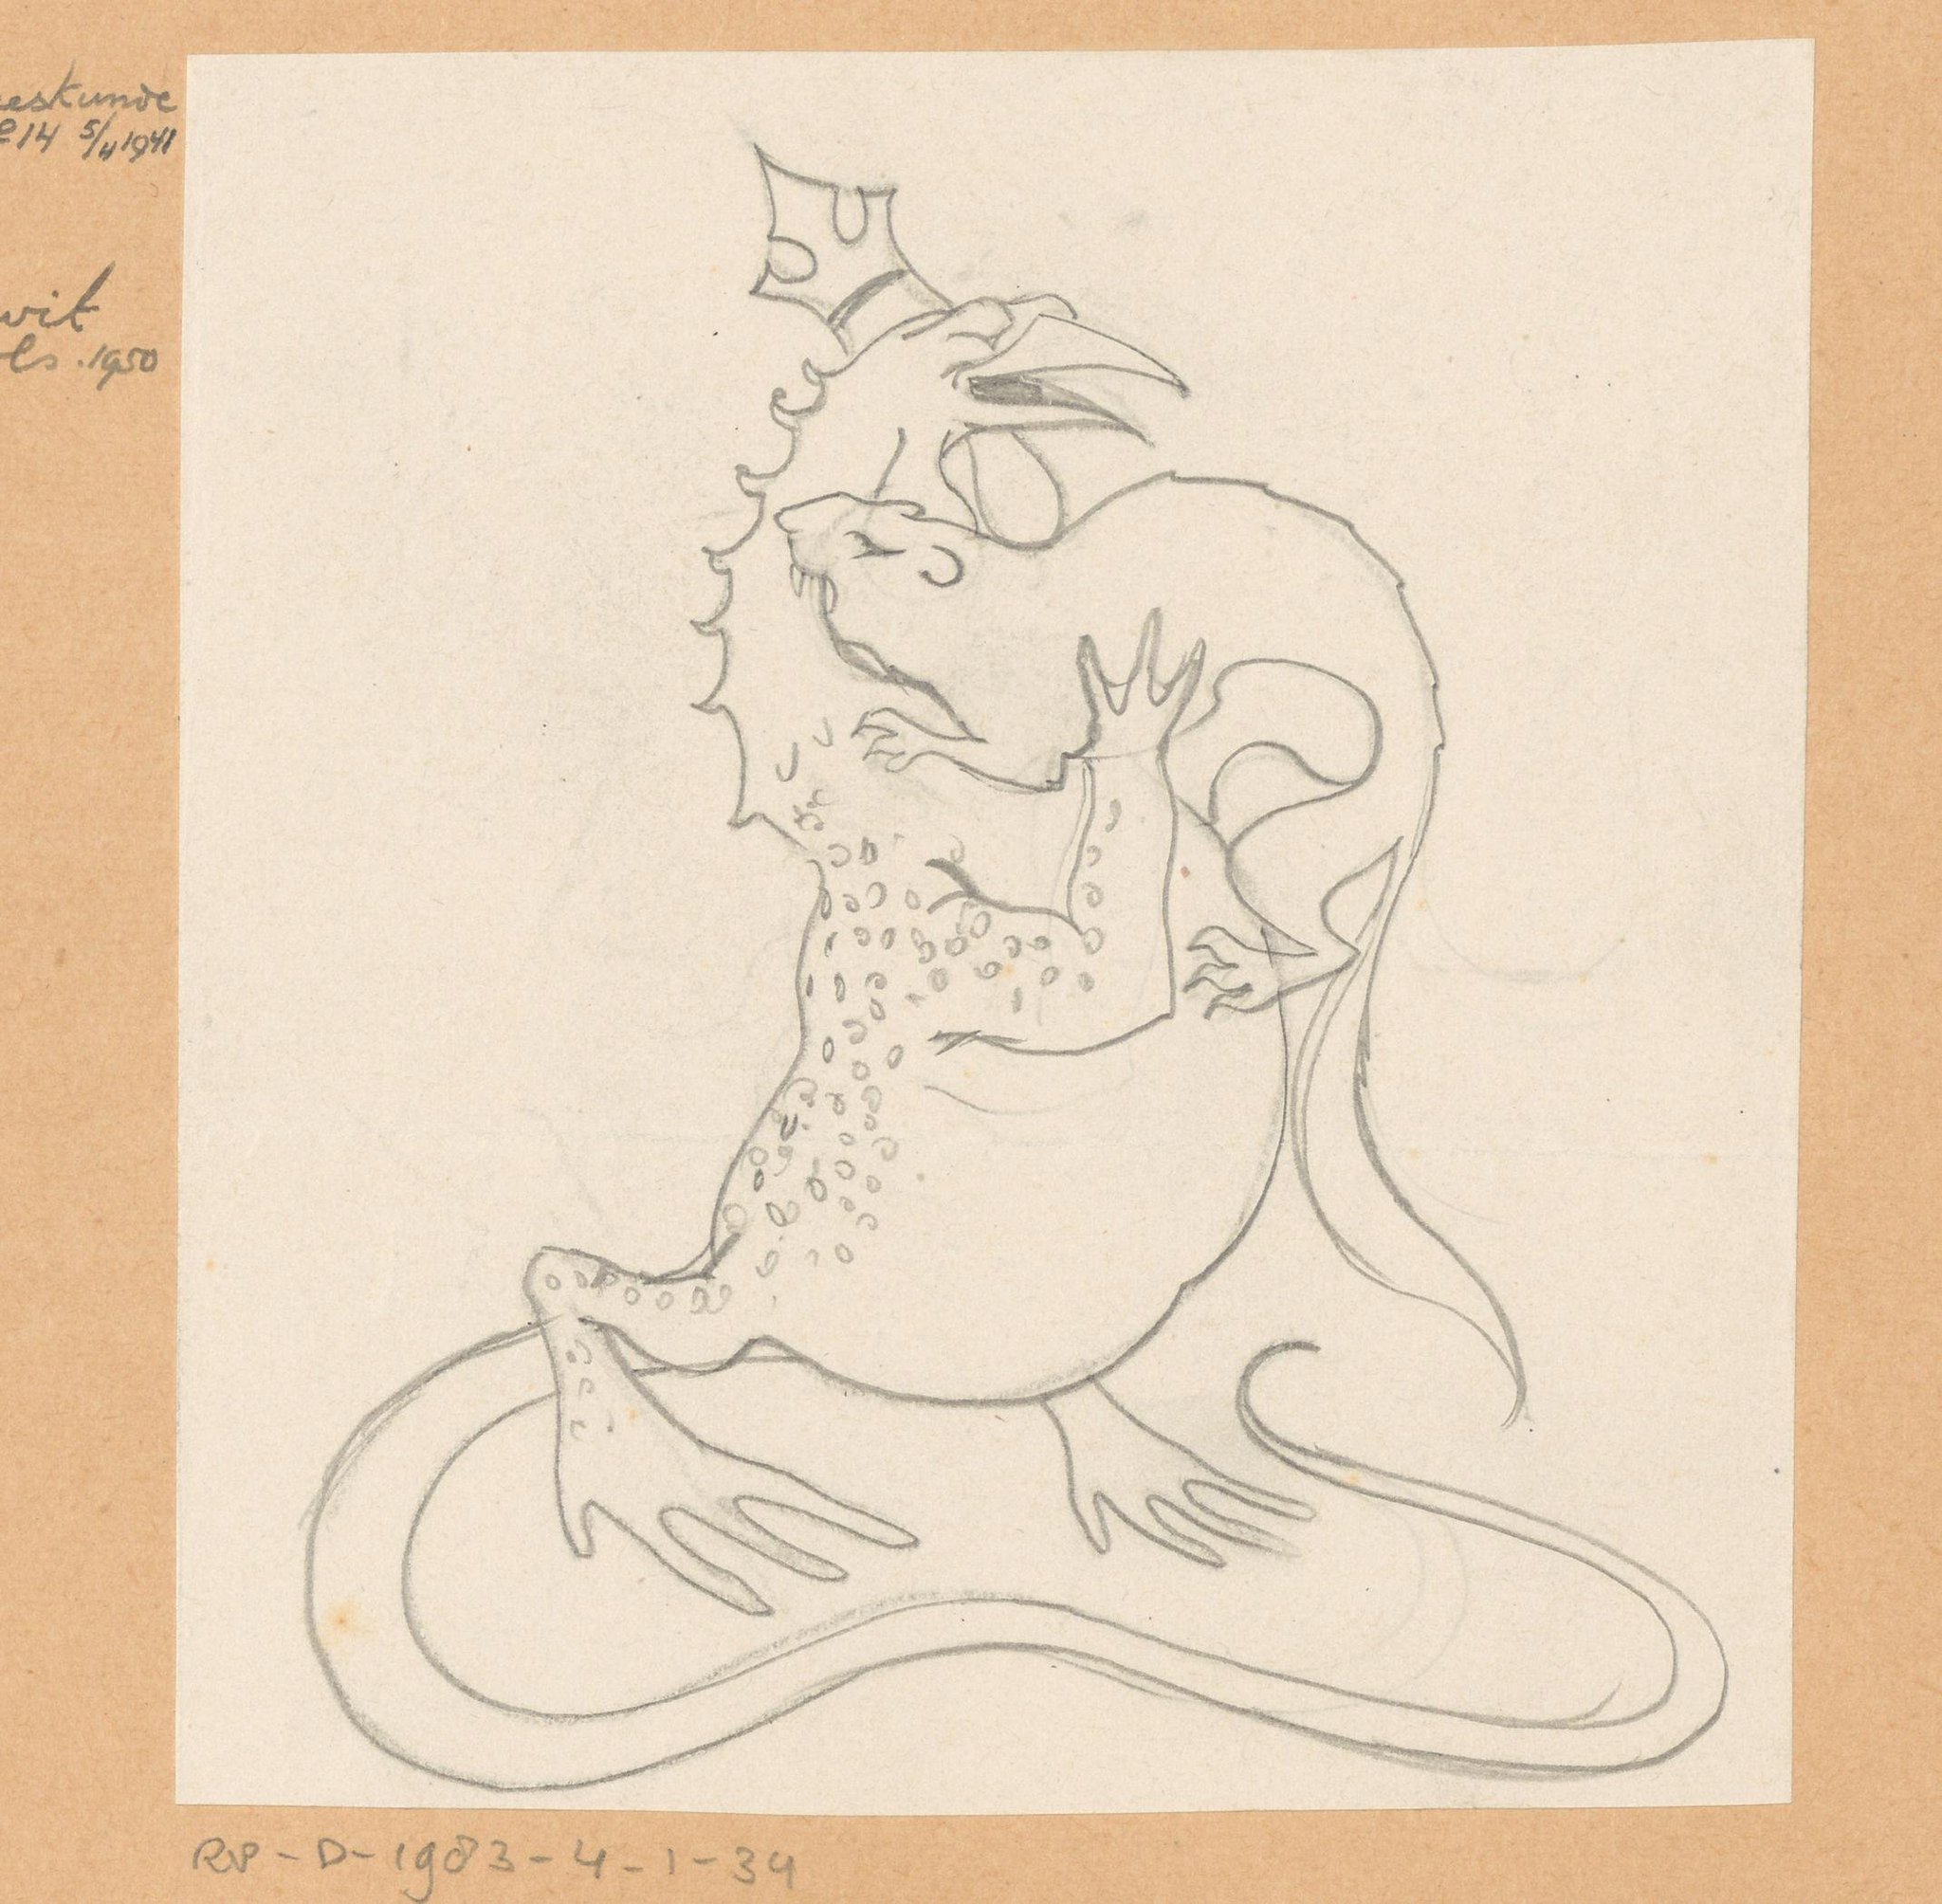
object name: design drawing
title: Ontwerp voor ex libris van F.A. Schaly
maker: otto verhagen (i)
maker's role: draughtsman, print maker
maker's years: 1885-1951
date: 1929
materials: paper, pencil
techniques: drawing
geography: netherlands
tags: crown (symbol of sovereignty), griffin (lion/eagle); 'griffo' (ripa), rodents: rat